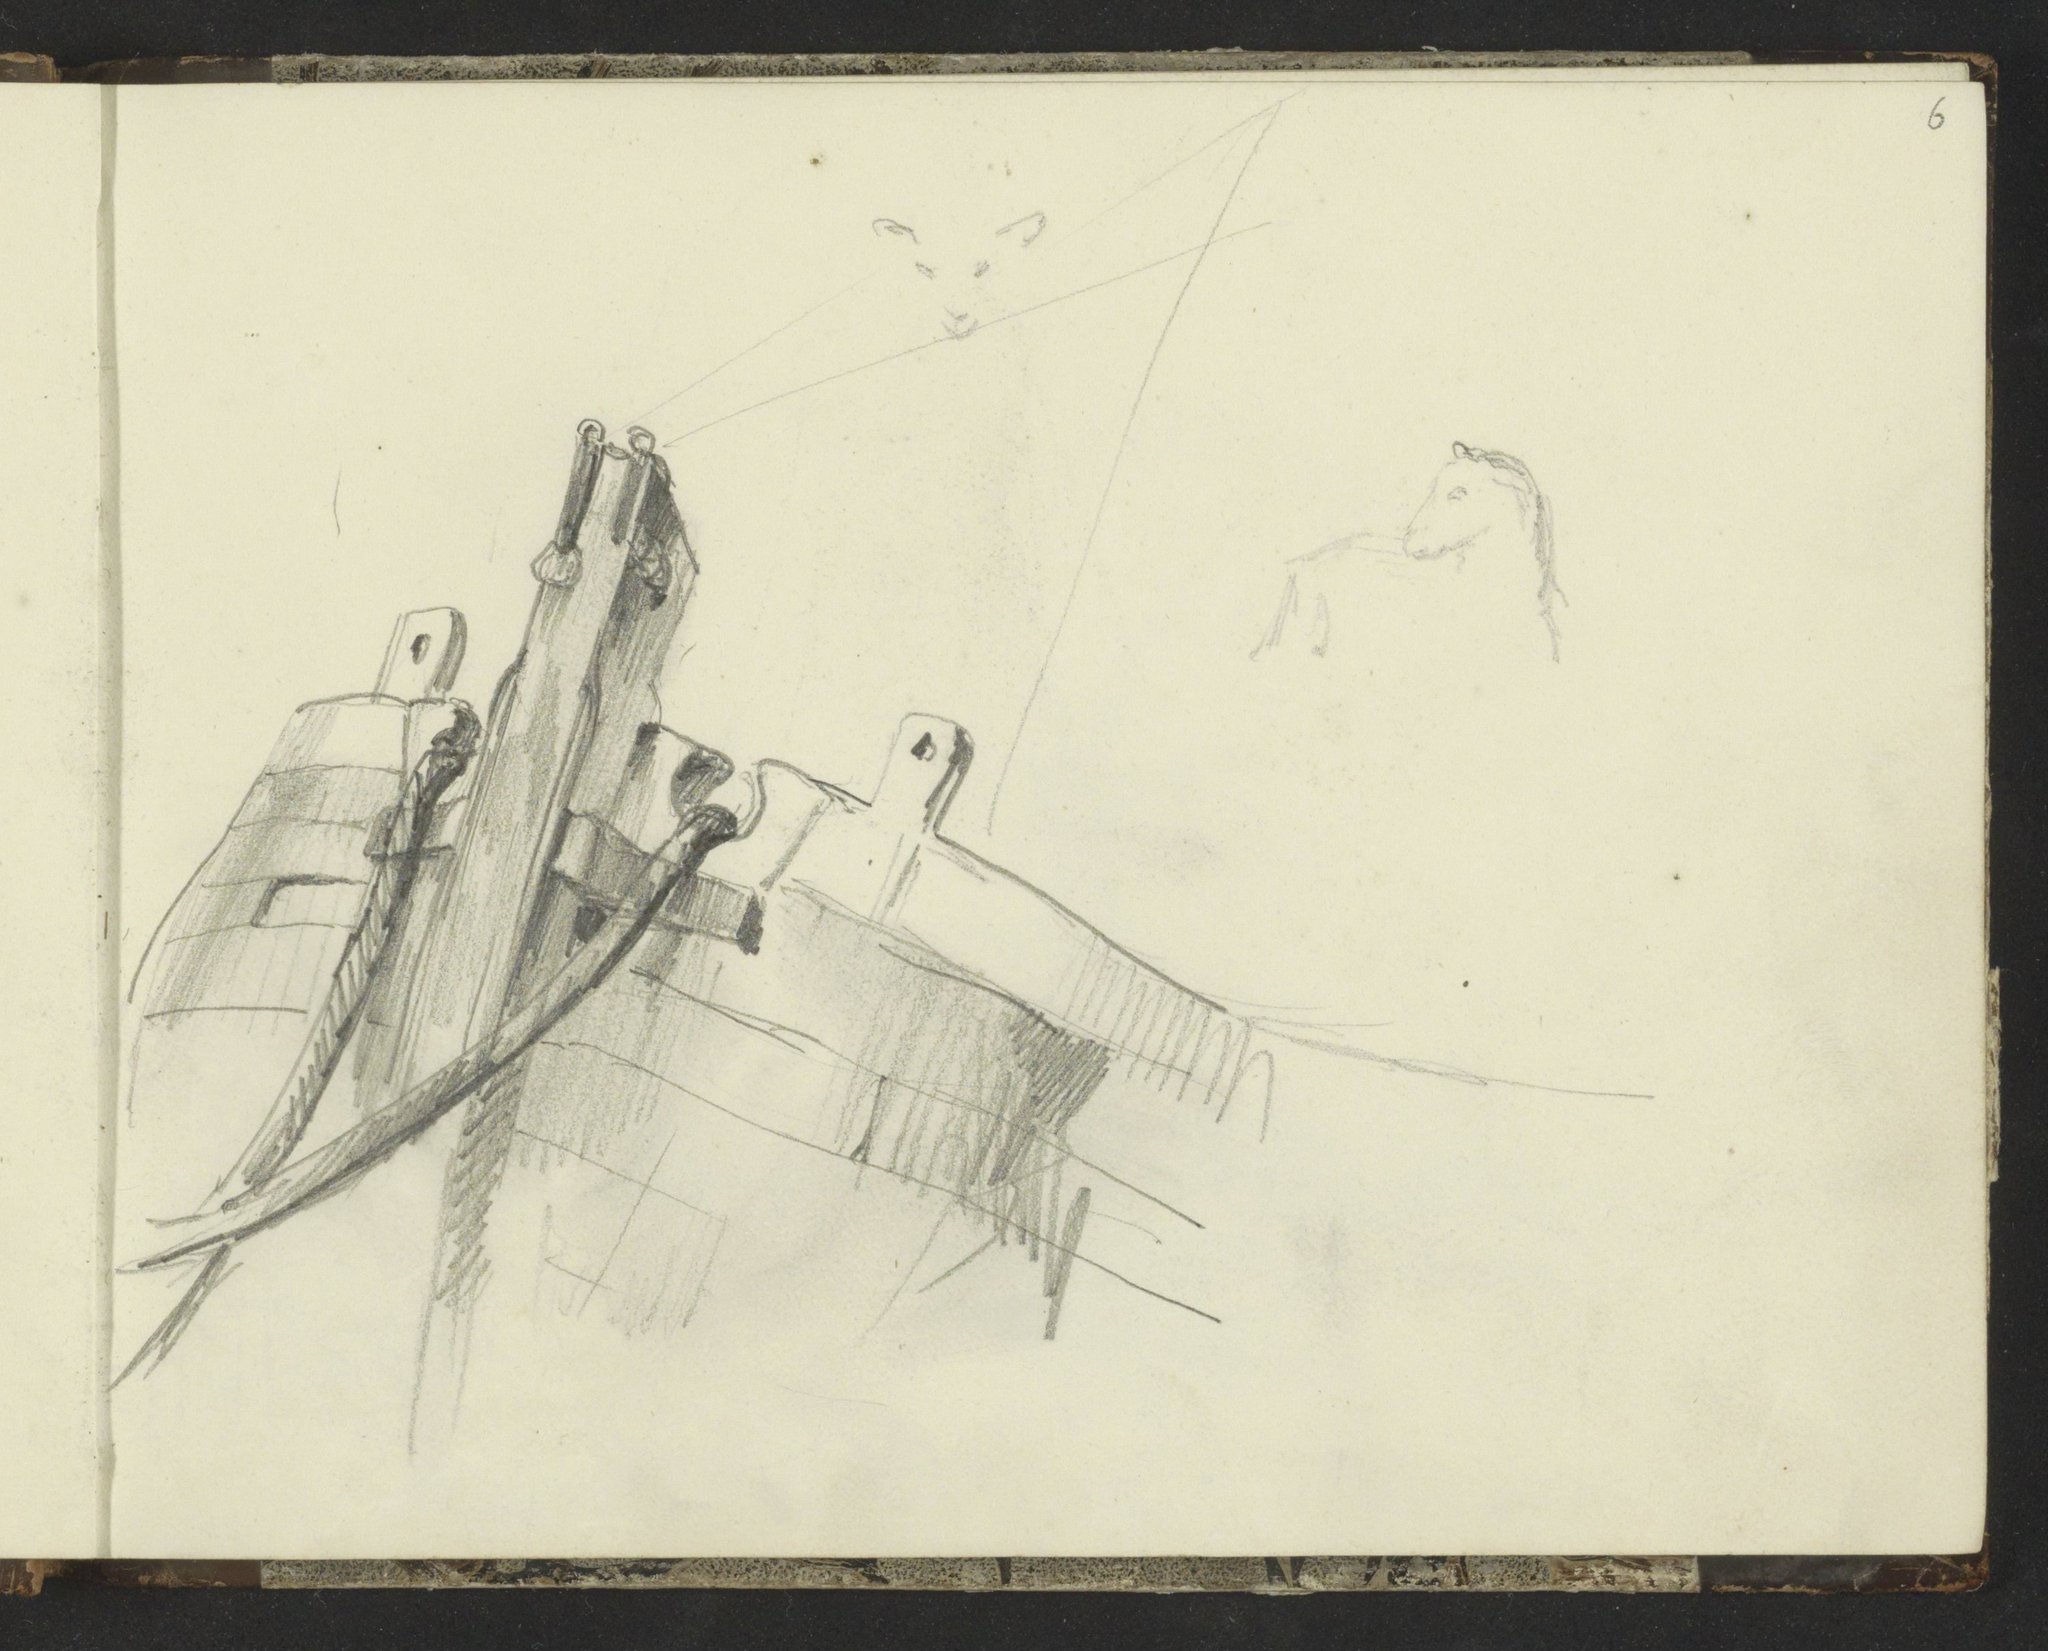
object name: sketchbook leaf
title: Achtersteven van een houten zeilboot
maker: willem hendrik schmidt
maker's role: draughtsman, painter, print maker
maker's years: 1809-1849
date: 1819-1849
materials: paper, pencil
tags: parts of ship's exterior: stern, horse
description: Tevens een studie van een paard en een kop van een dier, vermoedelijk een schaap. Blad 6 recto uit een schetsboek met 58 bladen.